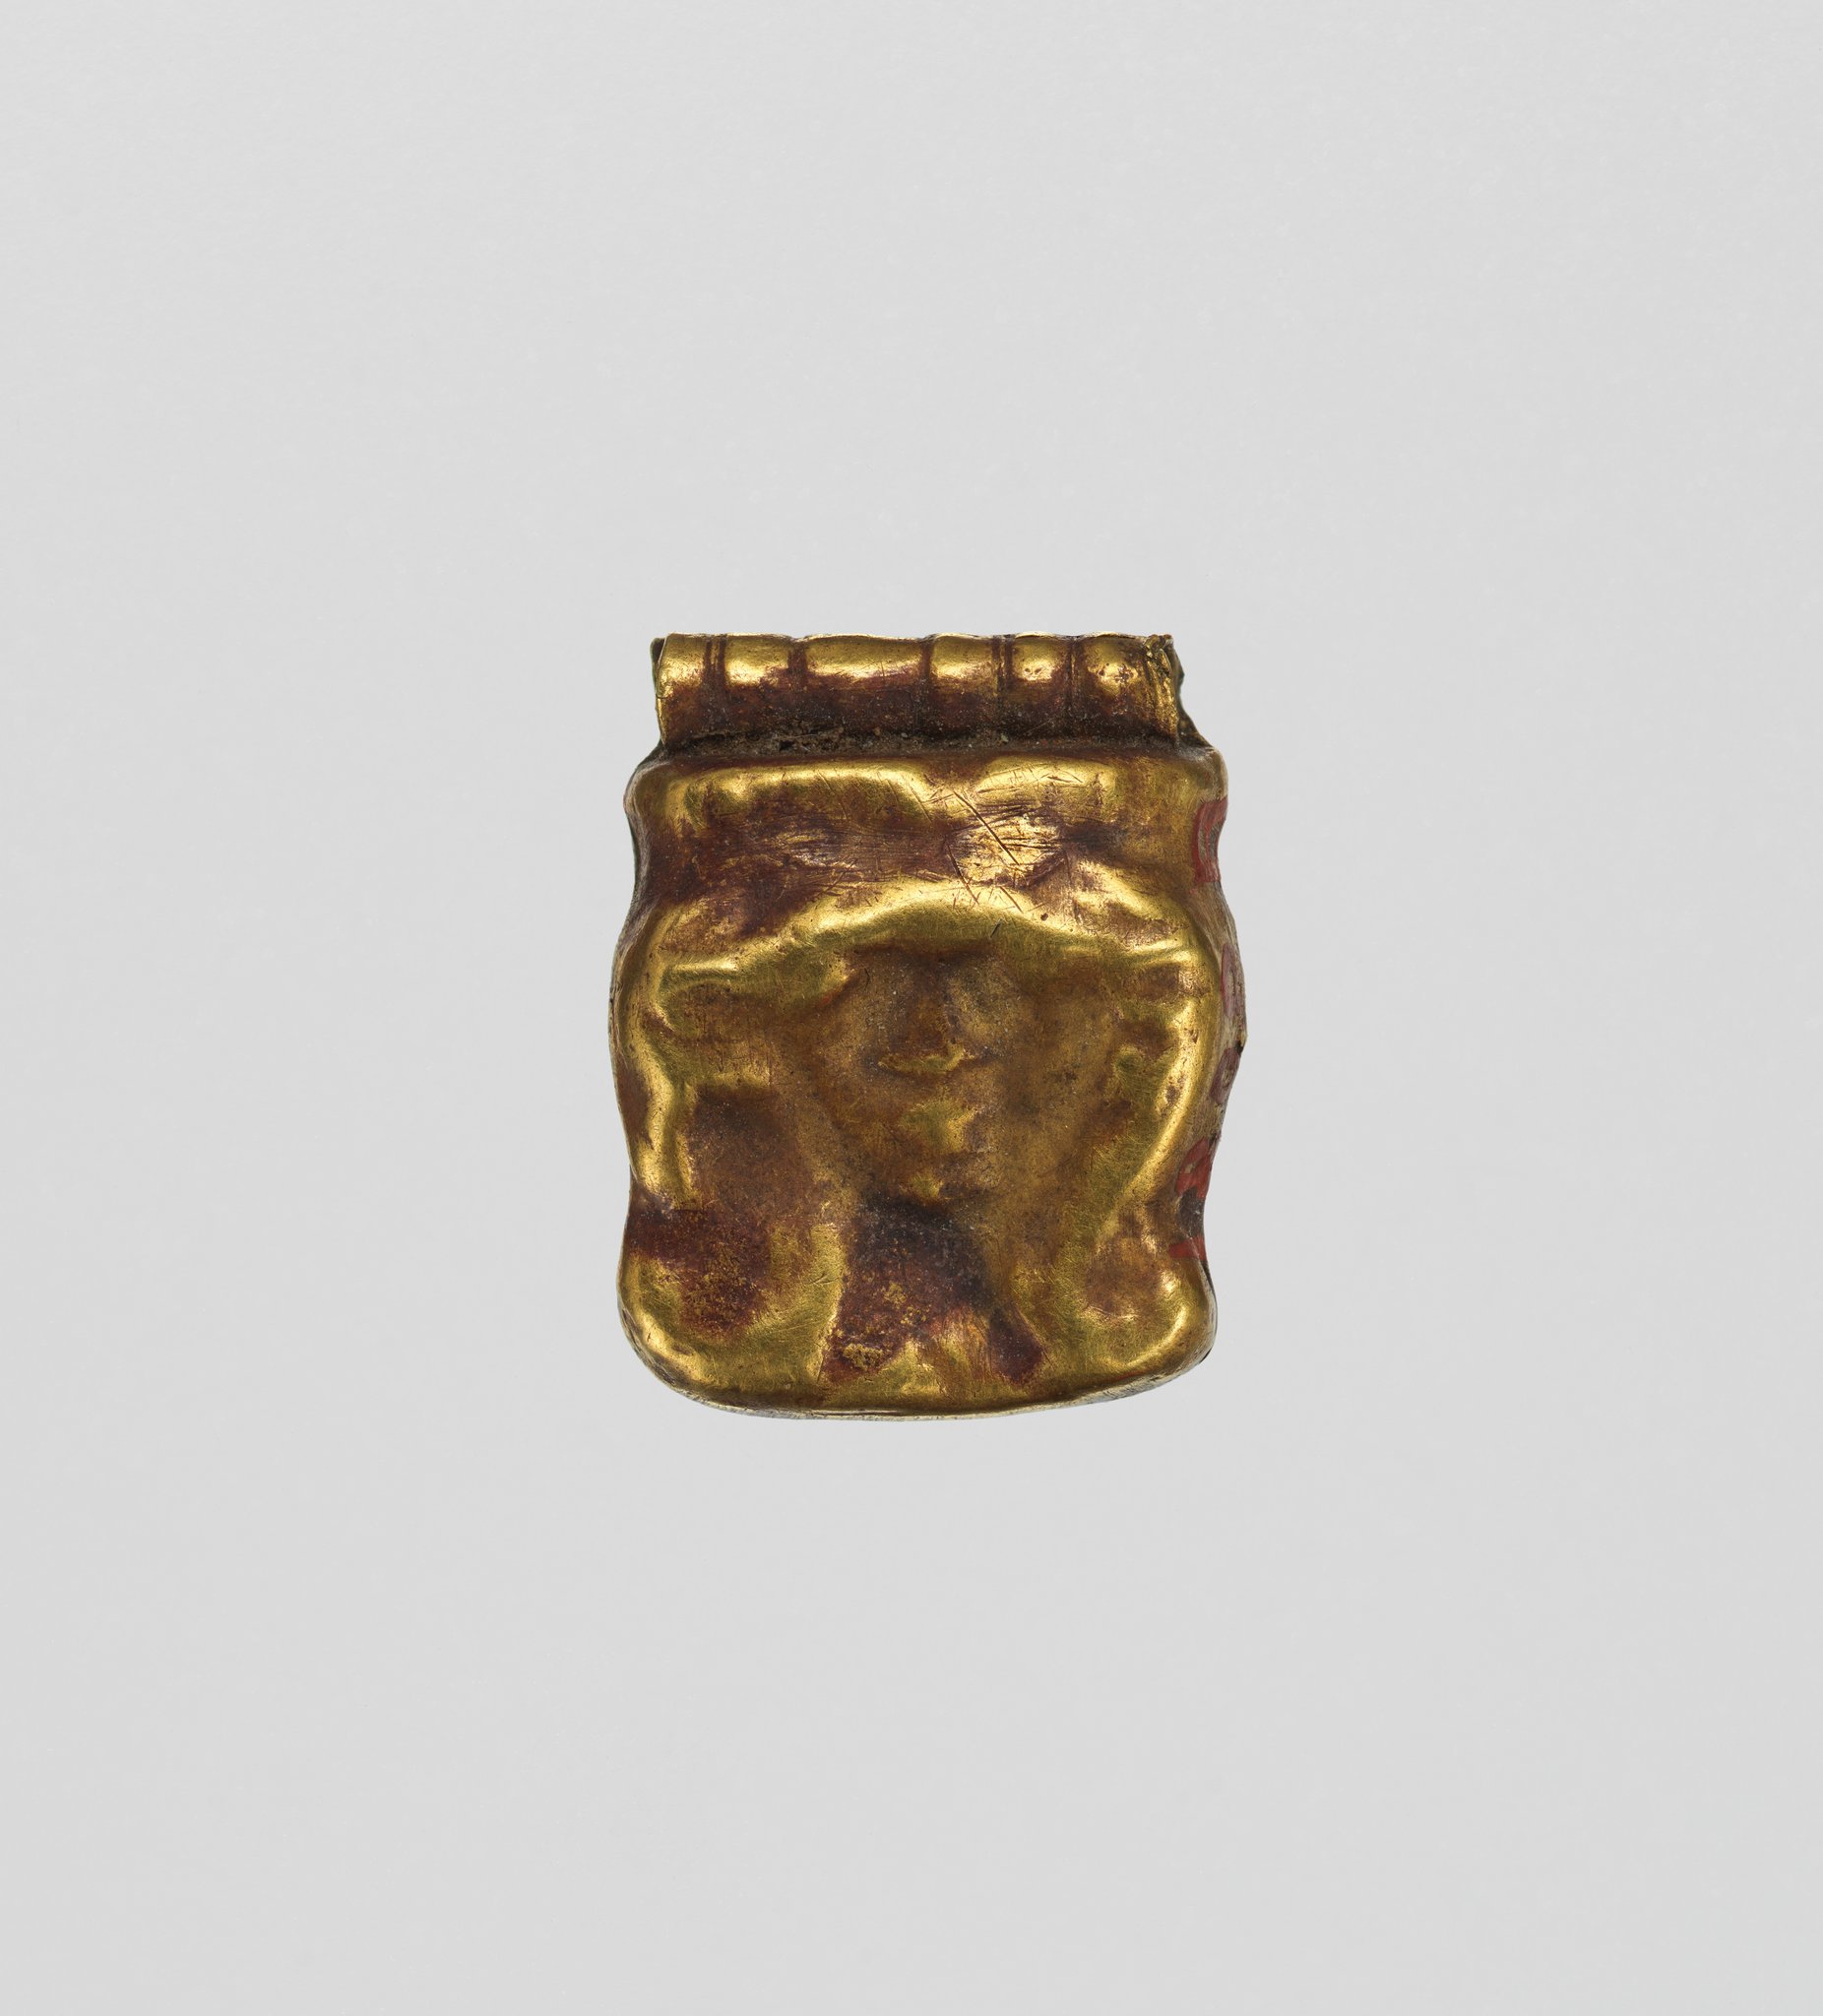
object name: pendant section, hathor head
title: Pendant section, Hathor head (?)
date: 332-330 BCE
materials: gold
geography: egypt